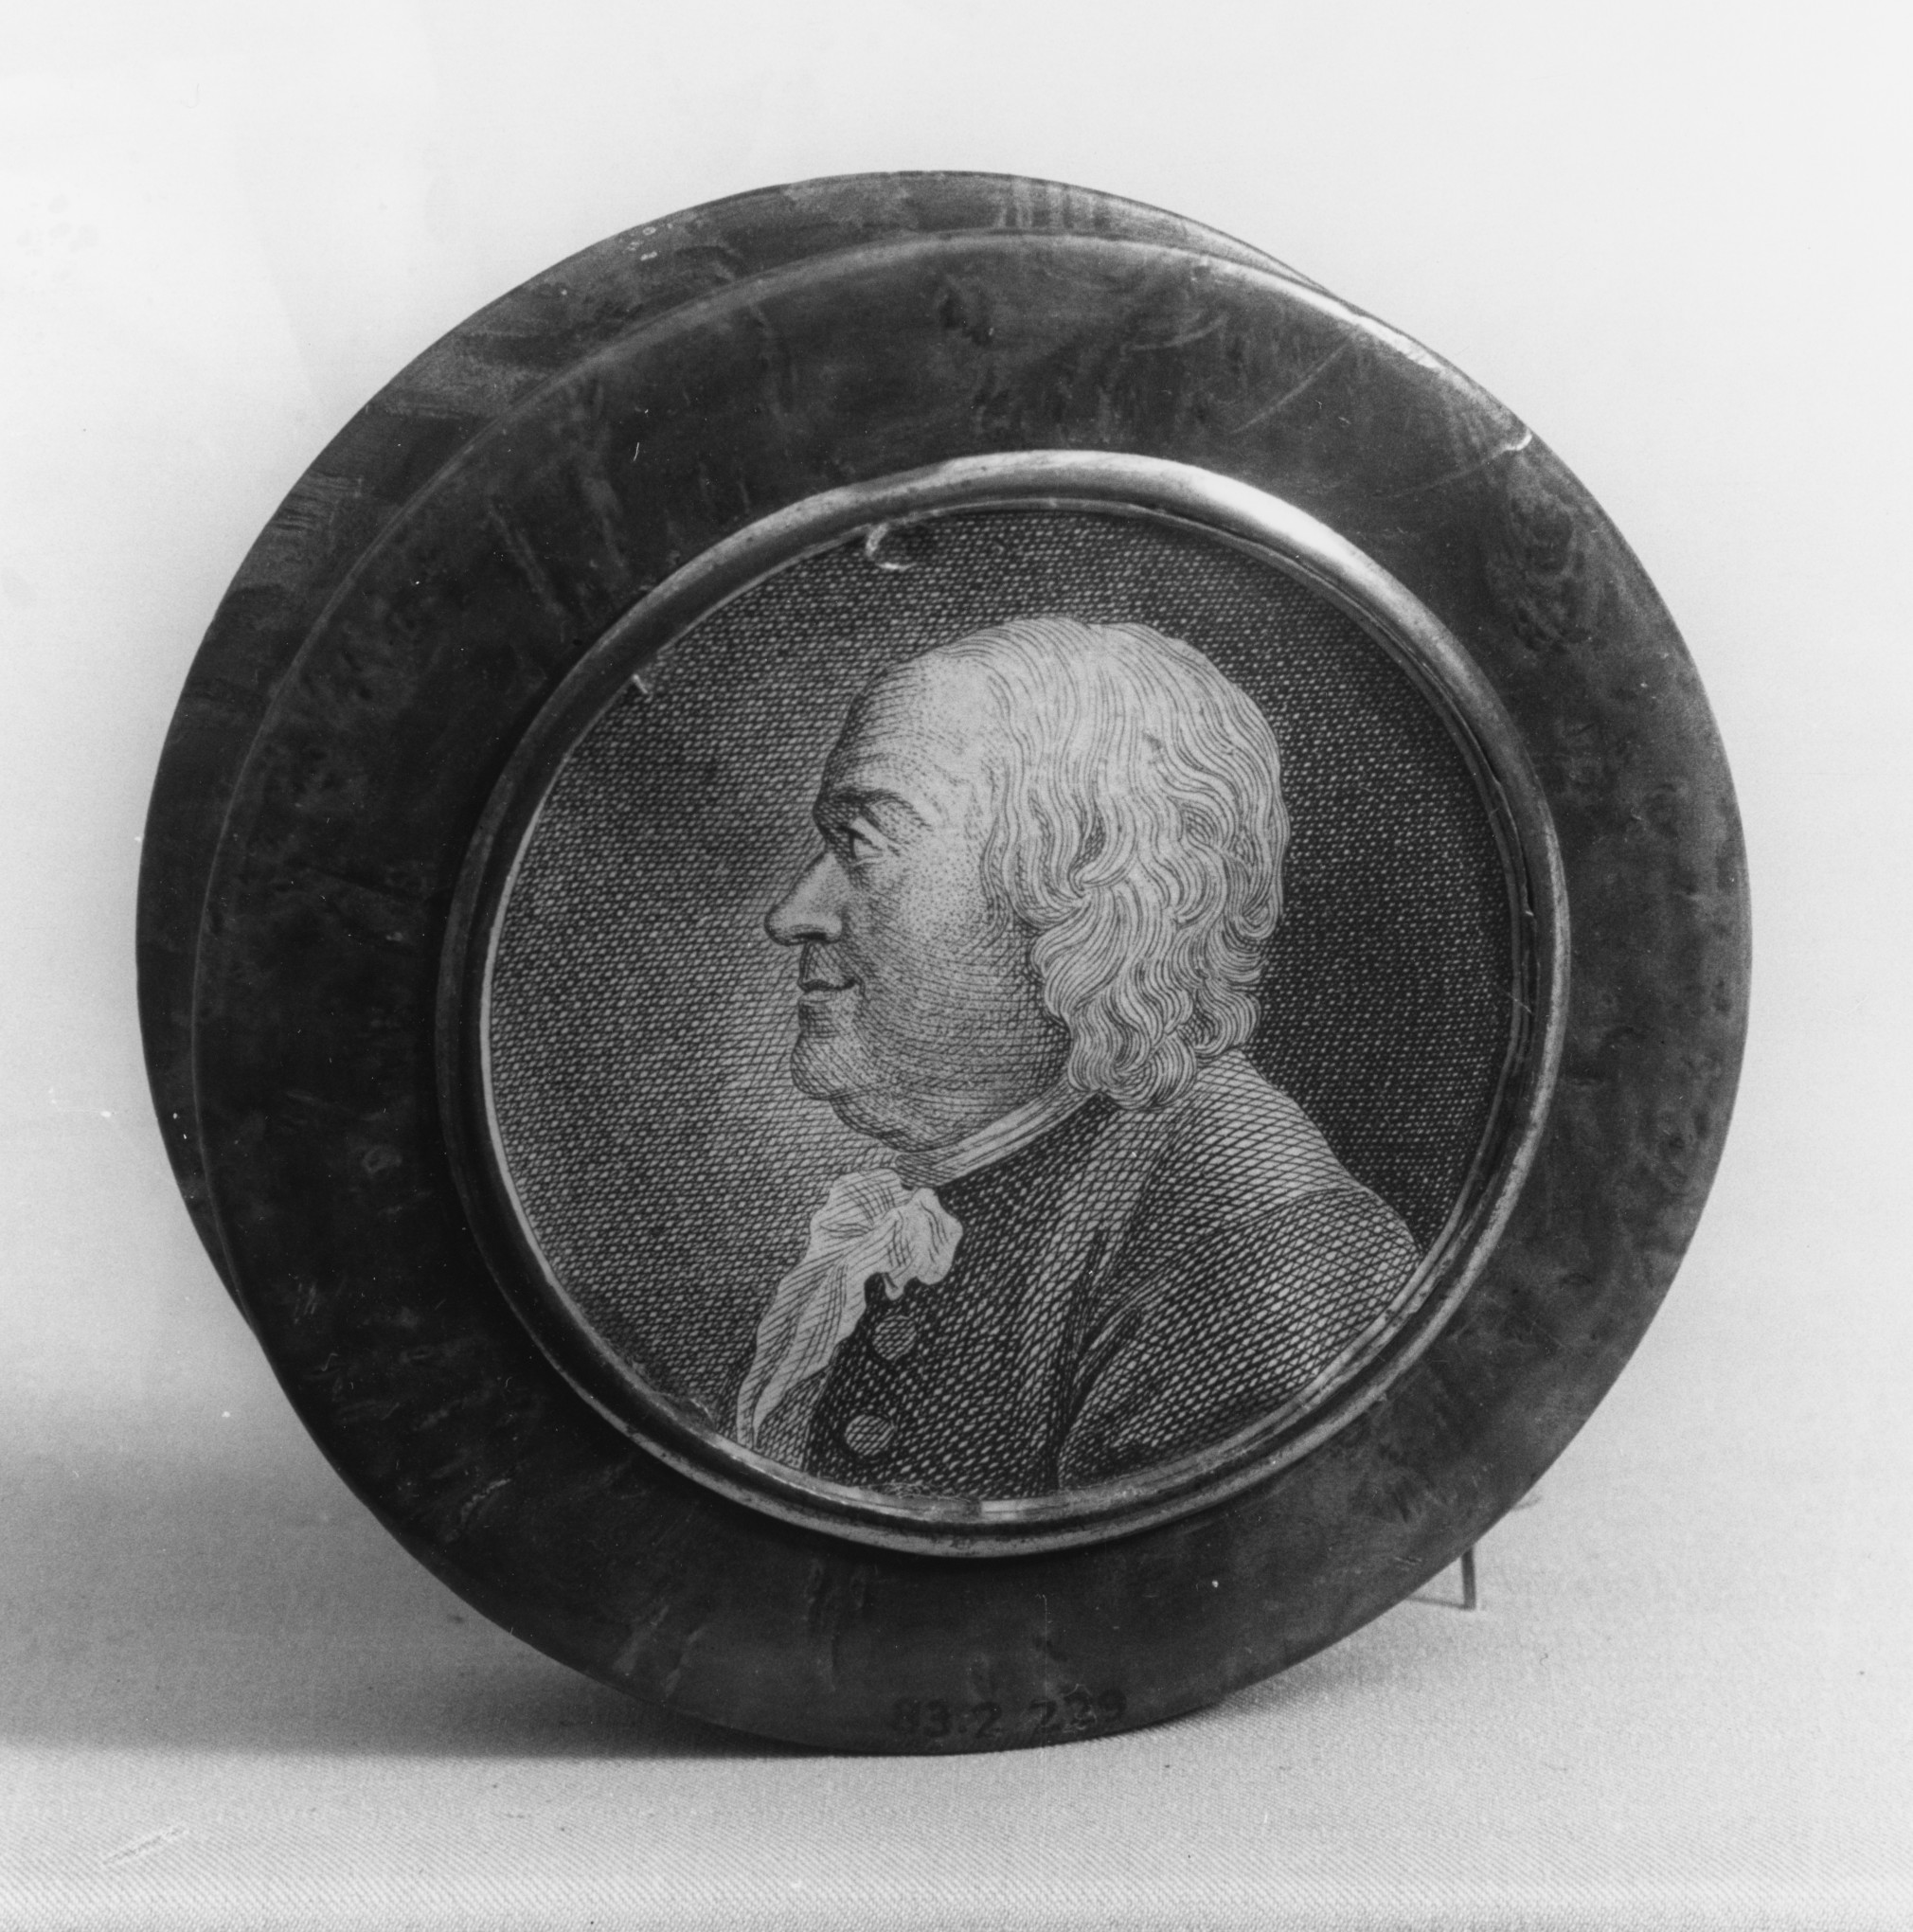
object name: box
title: Box with Medallion Top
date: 1760-1883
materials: gilt, glass, metal, shell, wood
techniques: engraving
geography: france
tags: benjamin franklin,men